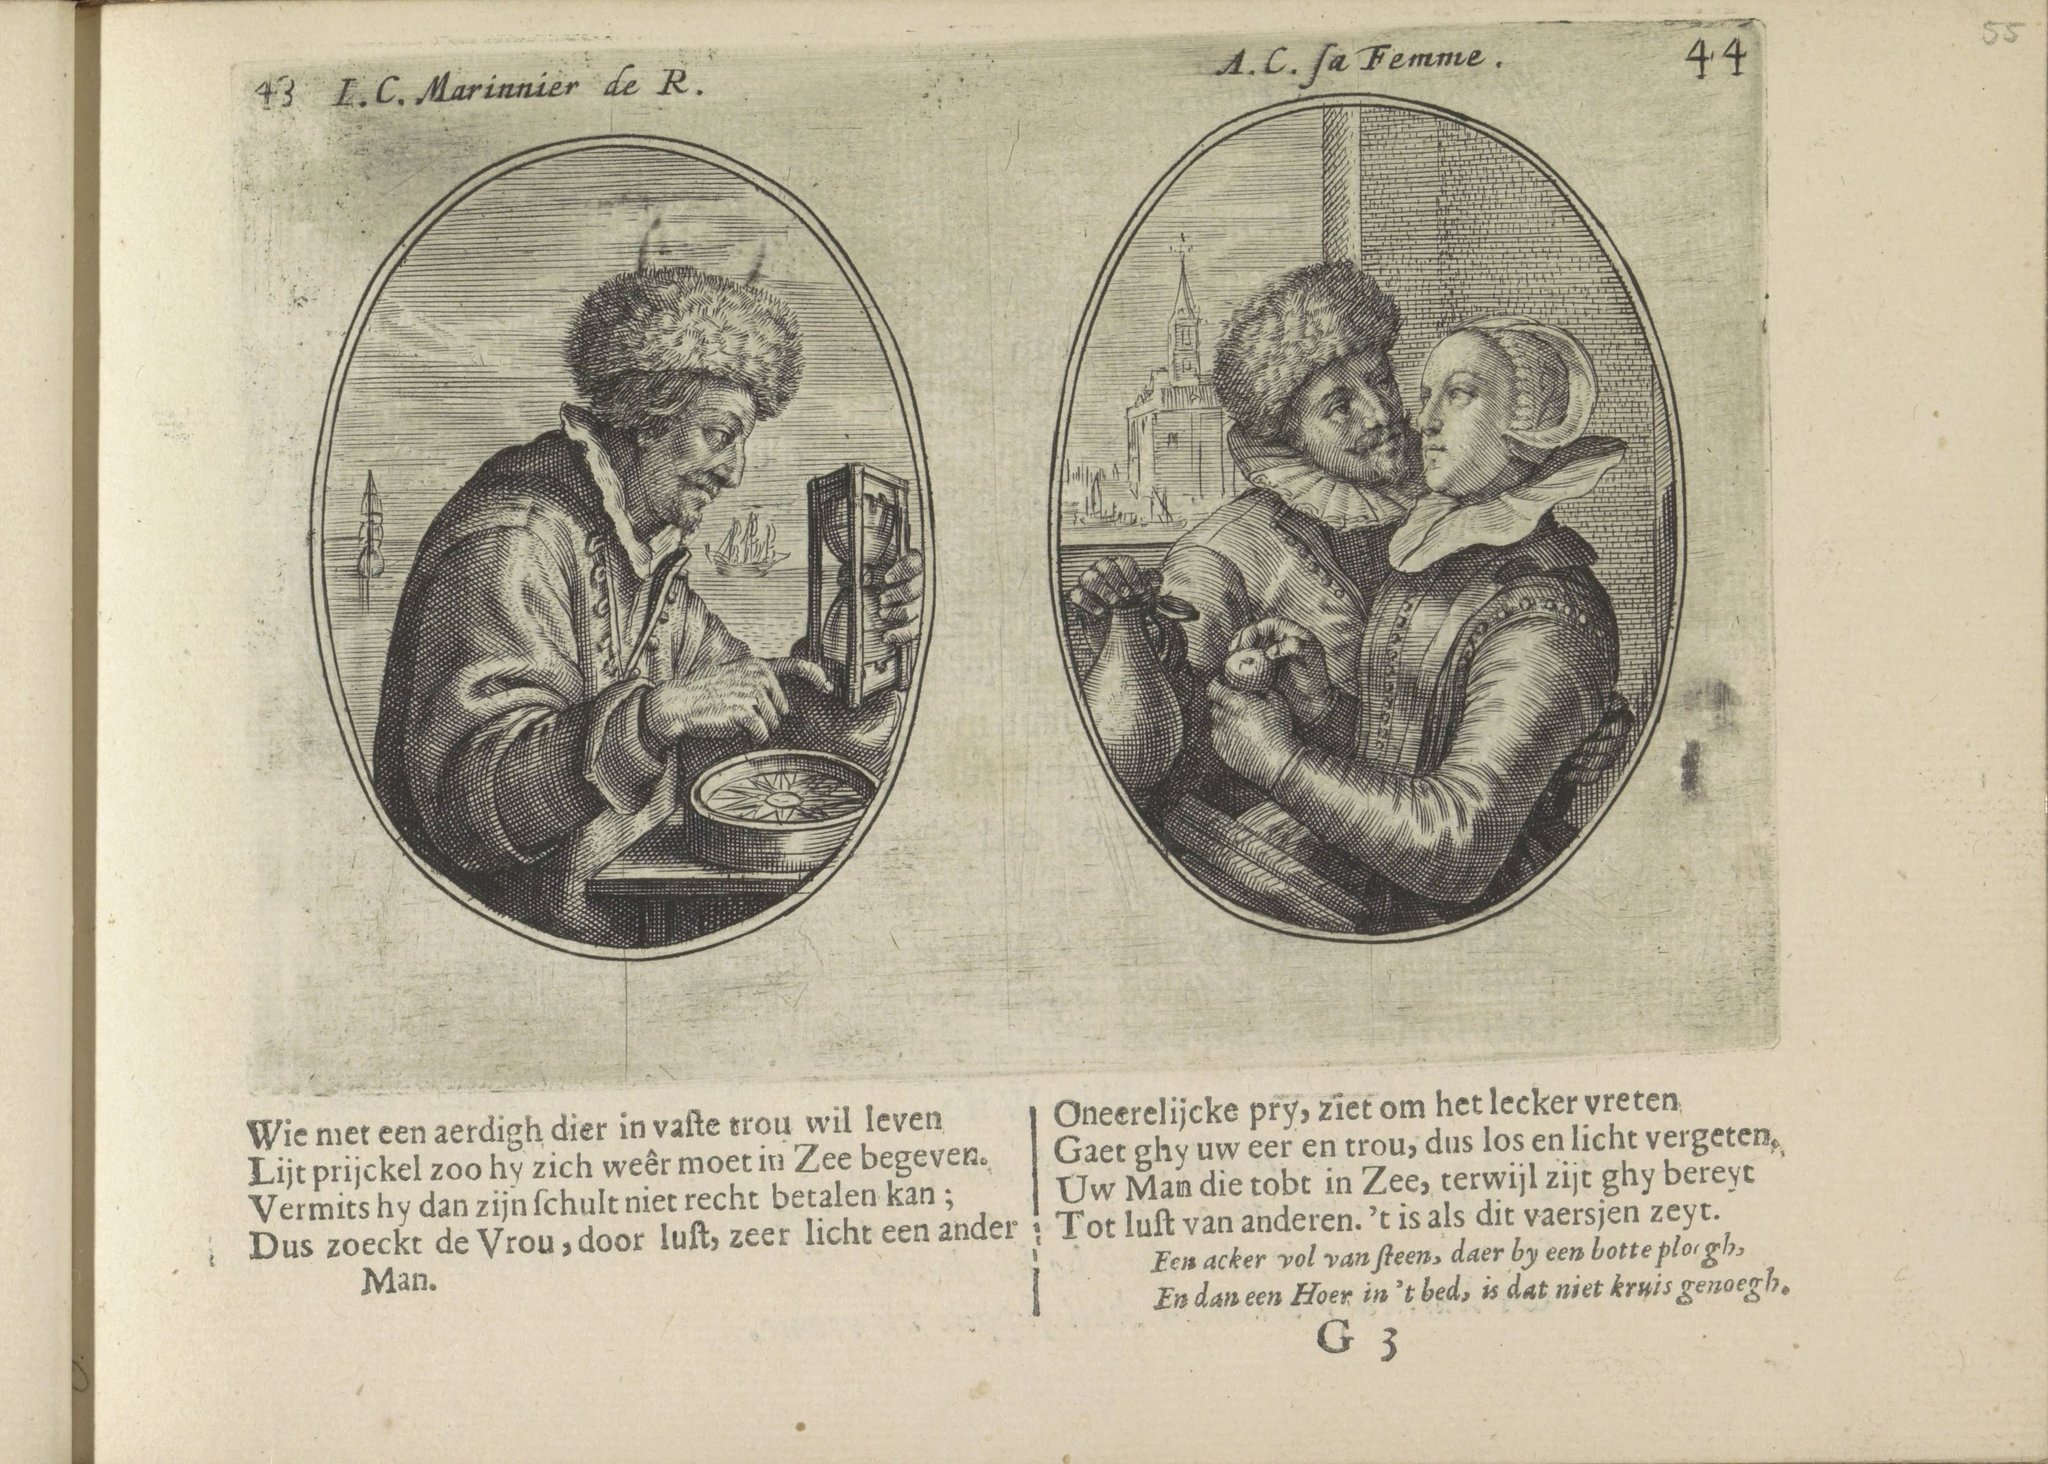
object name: album leaf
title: Les abus du mariage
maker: crispijn van de passe (ii)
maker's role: draughtsman, print maker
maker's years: 1594-1670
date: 1641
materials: paper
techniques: engraving, letterpress printing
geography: amsterdam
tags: female sex; woman, hourglass, adultery, compass, couple of lovers, male sex; man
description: Twee voorstellingen op een albumblad. Links een stuurman met zandloper en kompas. Op de achtergrond de zee en enkele schepen. Rechts zit zijn vrouw naast een andere man. Zijn hand op een vaasje. De vrouw heeft een appel vast. Op de achtergrond een kerkgebouw en enkele schepen. Daaronder twee kwatrijnen in het Nederlands. De prent maakt deel uit van een album.